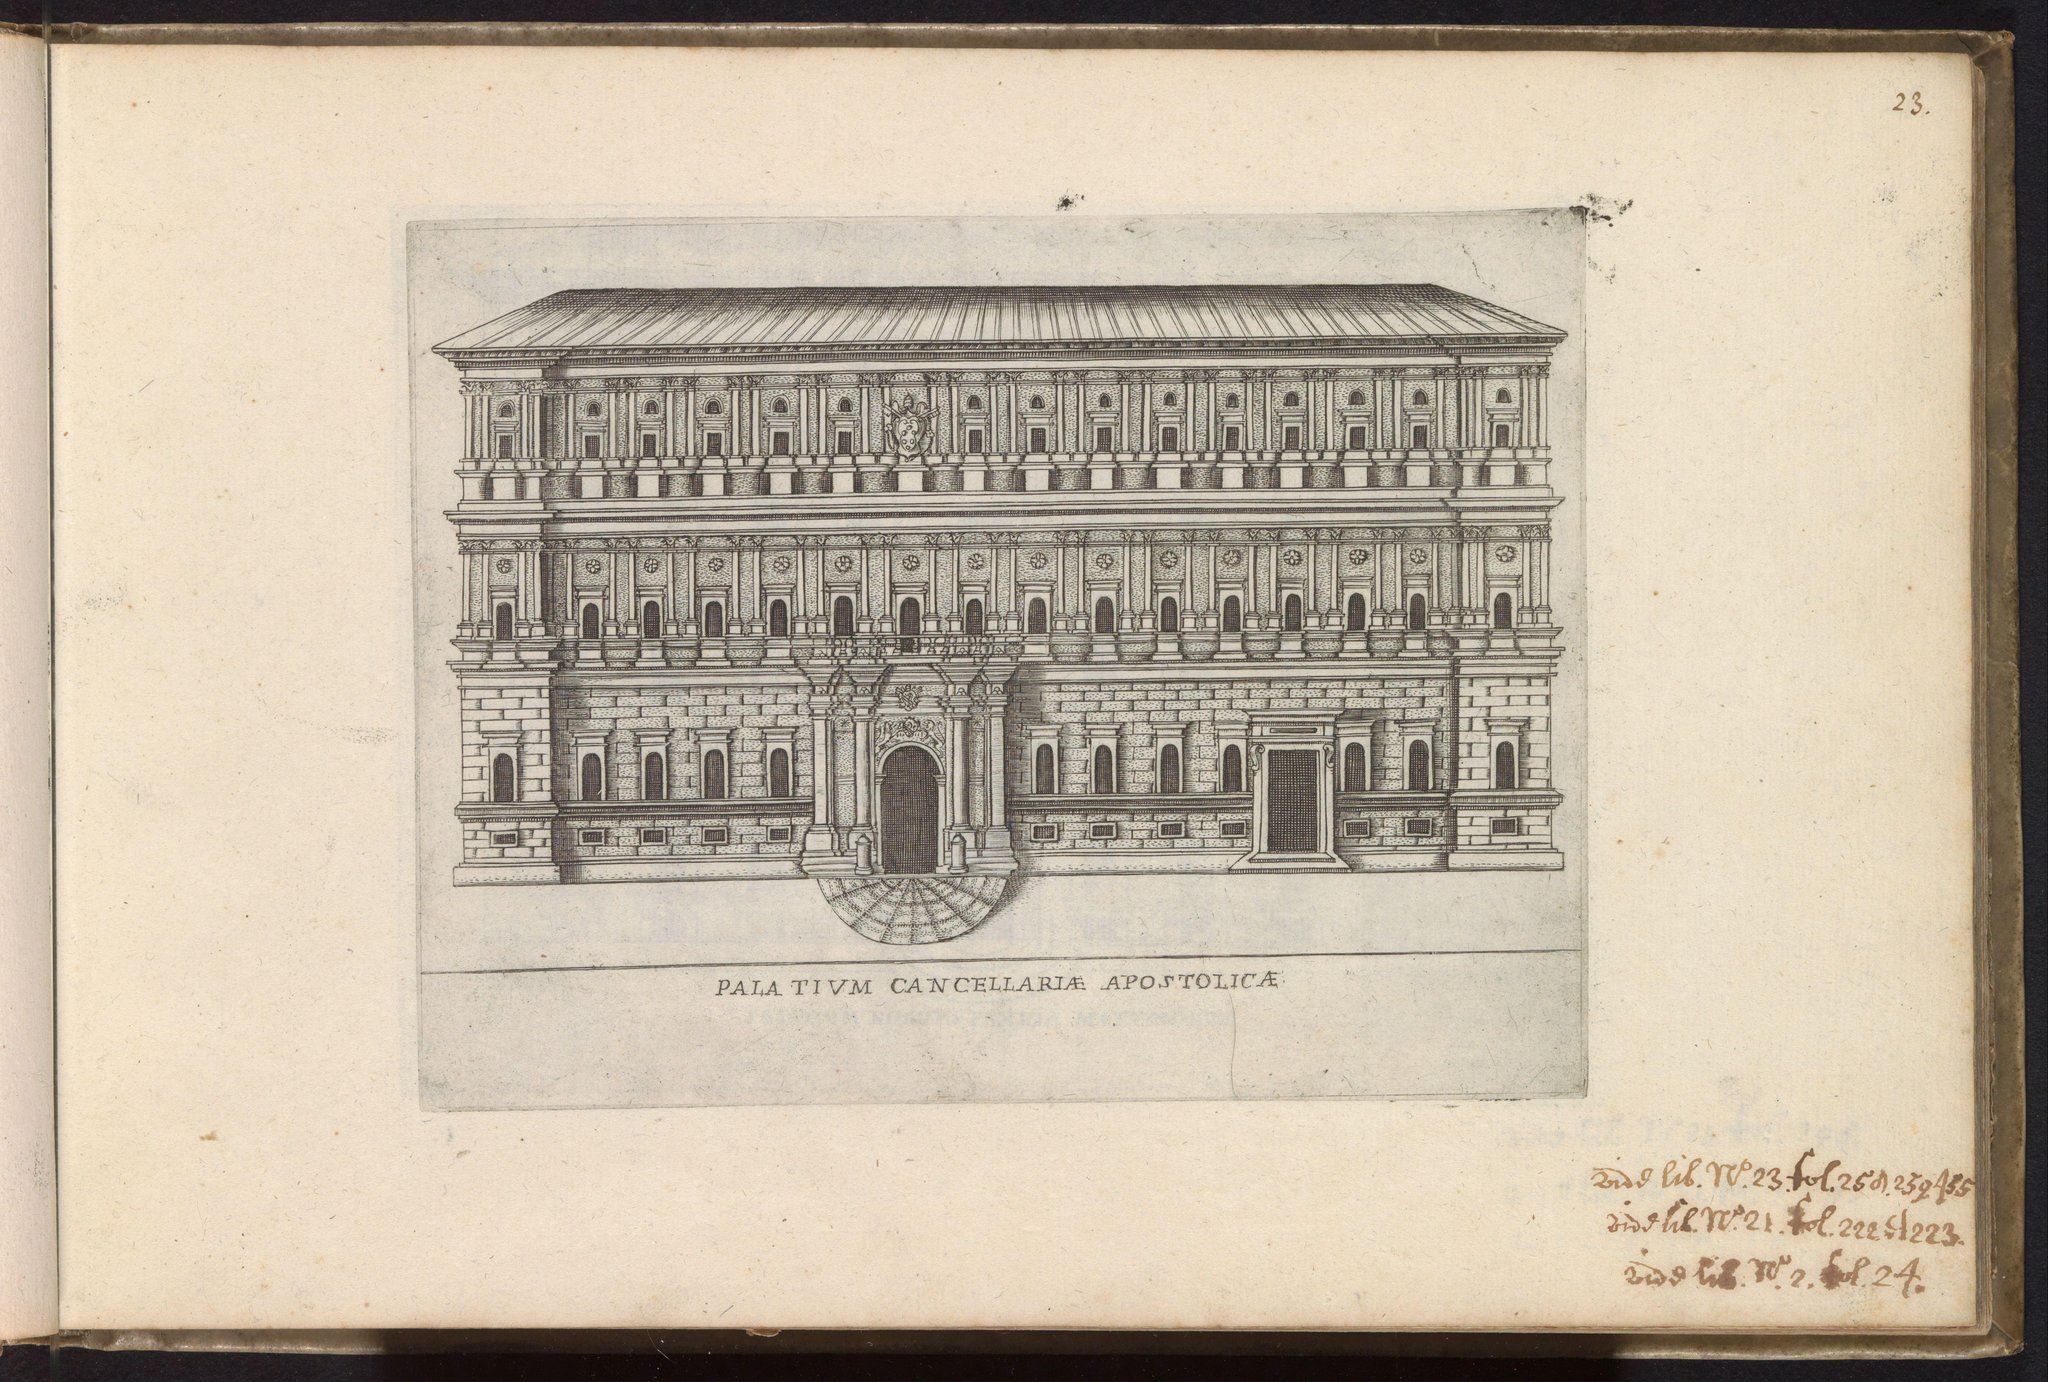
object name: print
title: Façade van een Romeins paleis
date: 1638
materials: paper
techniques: etching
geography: rome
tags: hôtel, i.e. small palace in city, façade (of house or building), rome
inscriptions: inscription: ‘Ende lib. No. 23. fol. 258. 259. 455/ Ende lib. No. 21. fol. 222 et 223./ Ende lib. No. 2. fol. 24.’, number: ‘23’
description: Prent maakt deel uit van een reeks prenten (+ titelprent) van beroemde gebouwen in Rome en elders.